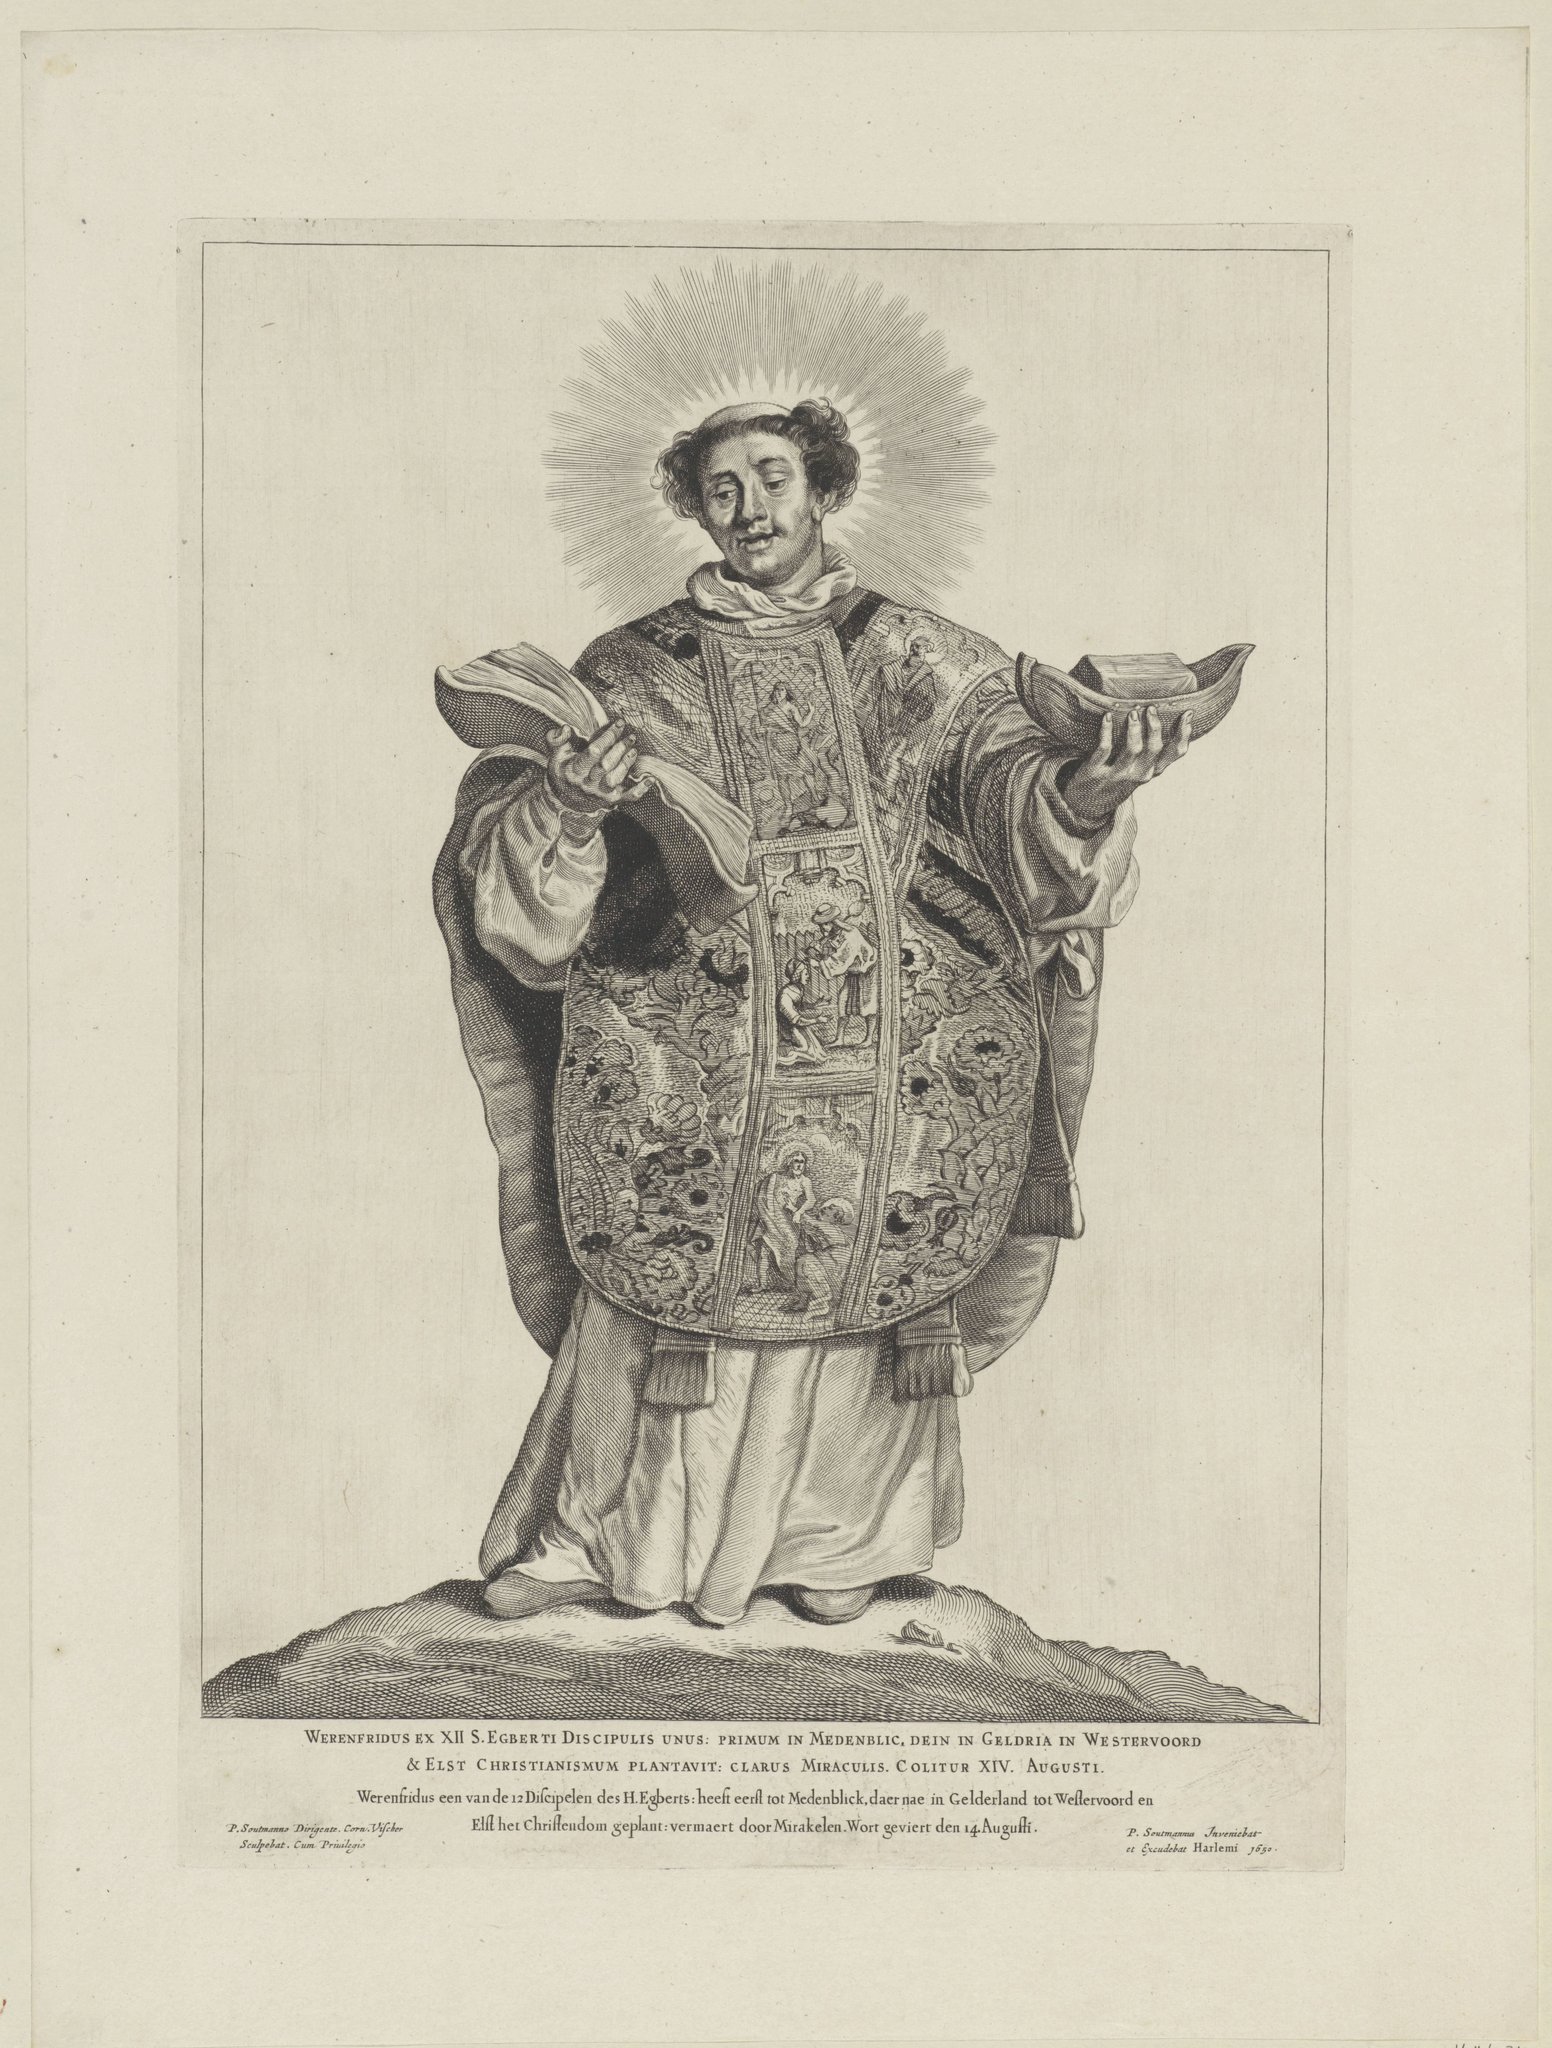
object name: print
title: Nederlandse heiligen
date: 1650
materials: paper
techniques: engraving, etching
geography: haarlem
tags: pastoor, werenfridus van elst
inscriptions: collector's mark: Lugt 240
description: De heilige Werenfridus is afgebeeld als een priester met tuniek, kazuifel en armdoek. Hij draagt een schip met zijn doodskist, zijn attribuut, in zijn handen. Na zijn dood waren er twisten over de plaats van zijn graf. De doodskist werd in een boot geplaatst en de boot dreef tegen de stroom in naar Elst, waar Werenfridus pastoor was geweest. Deze prent maakt deel uit van een reeks Nederlandse heiligen.